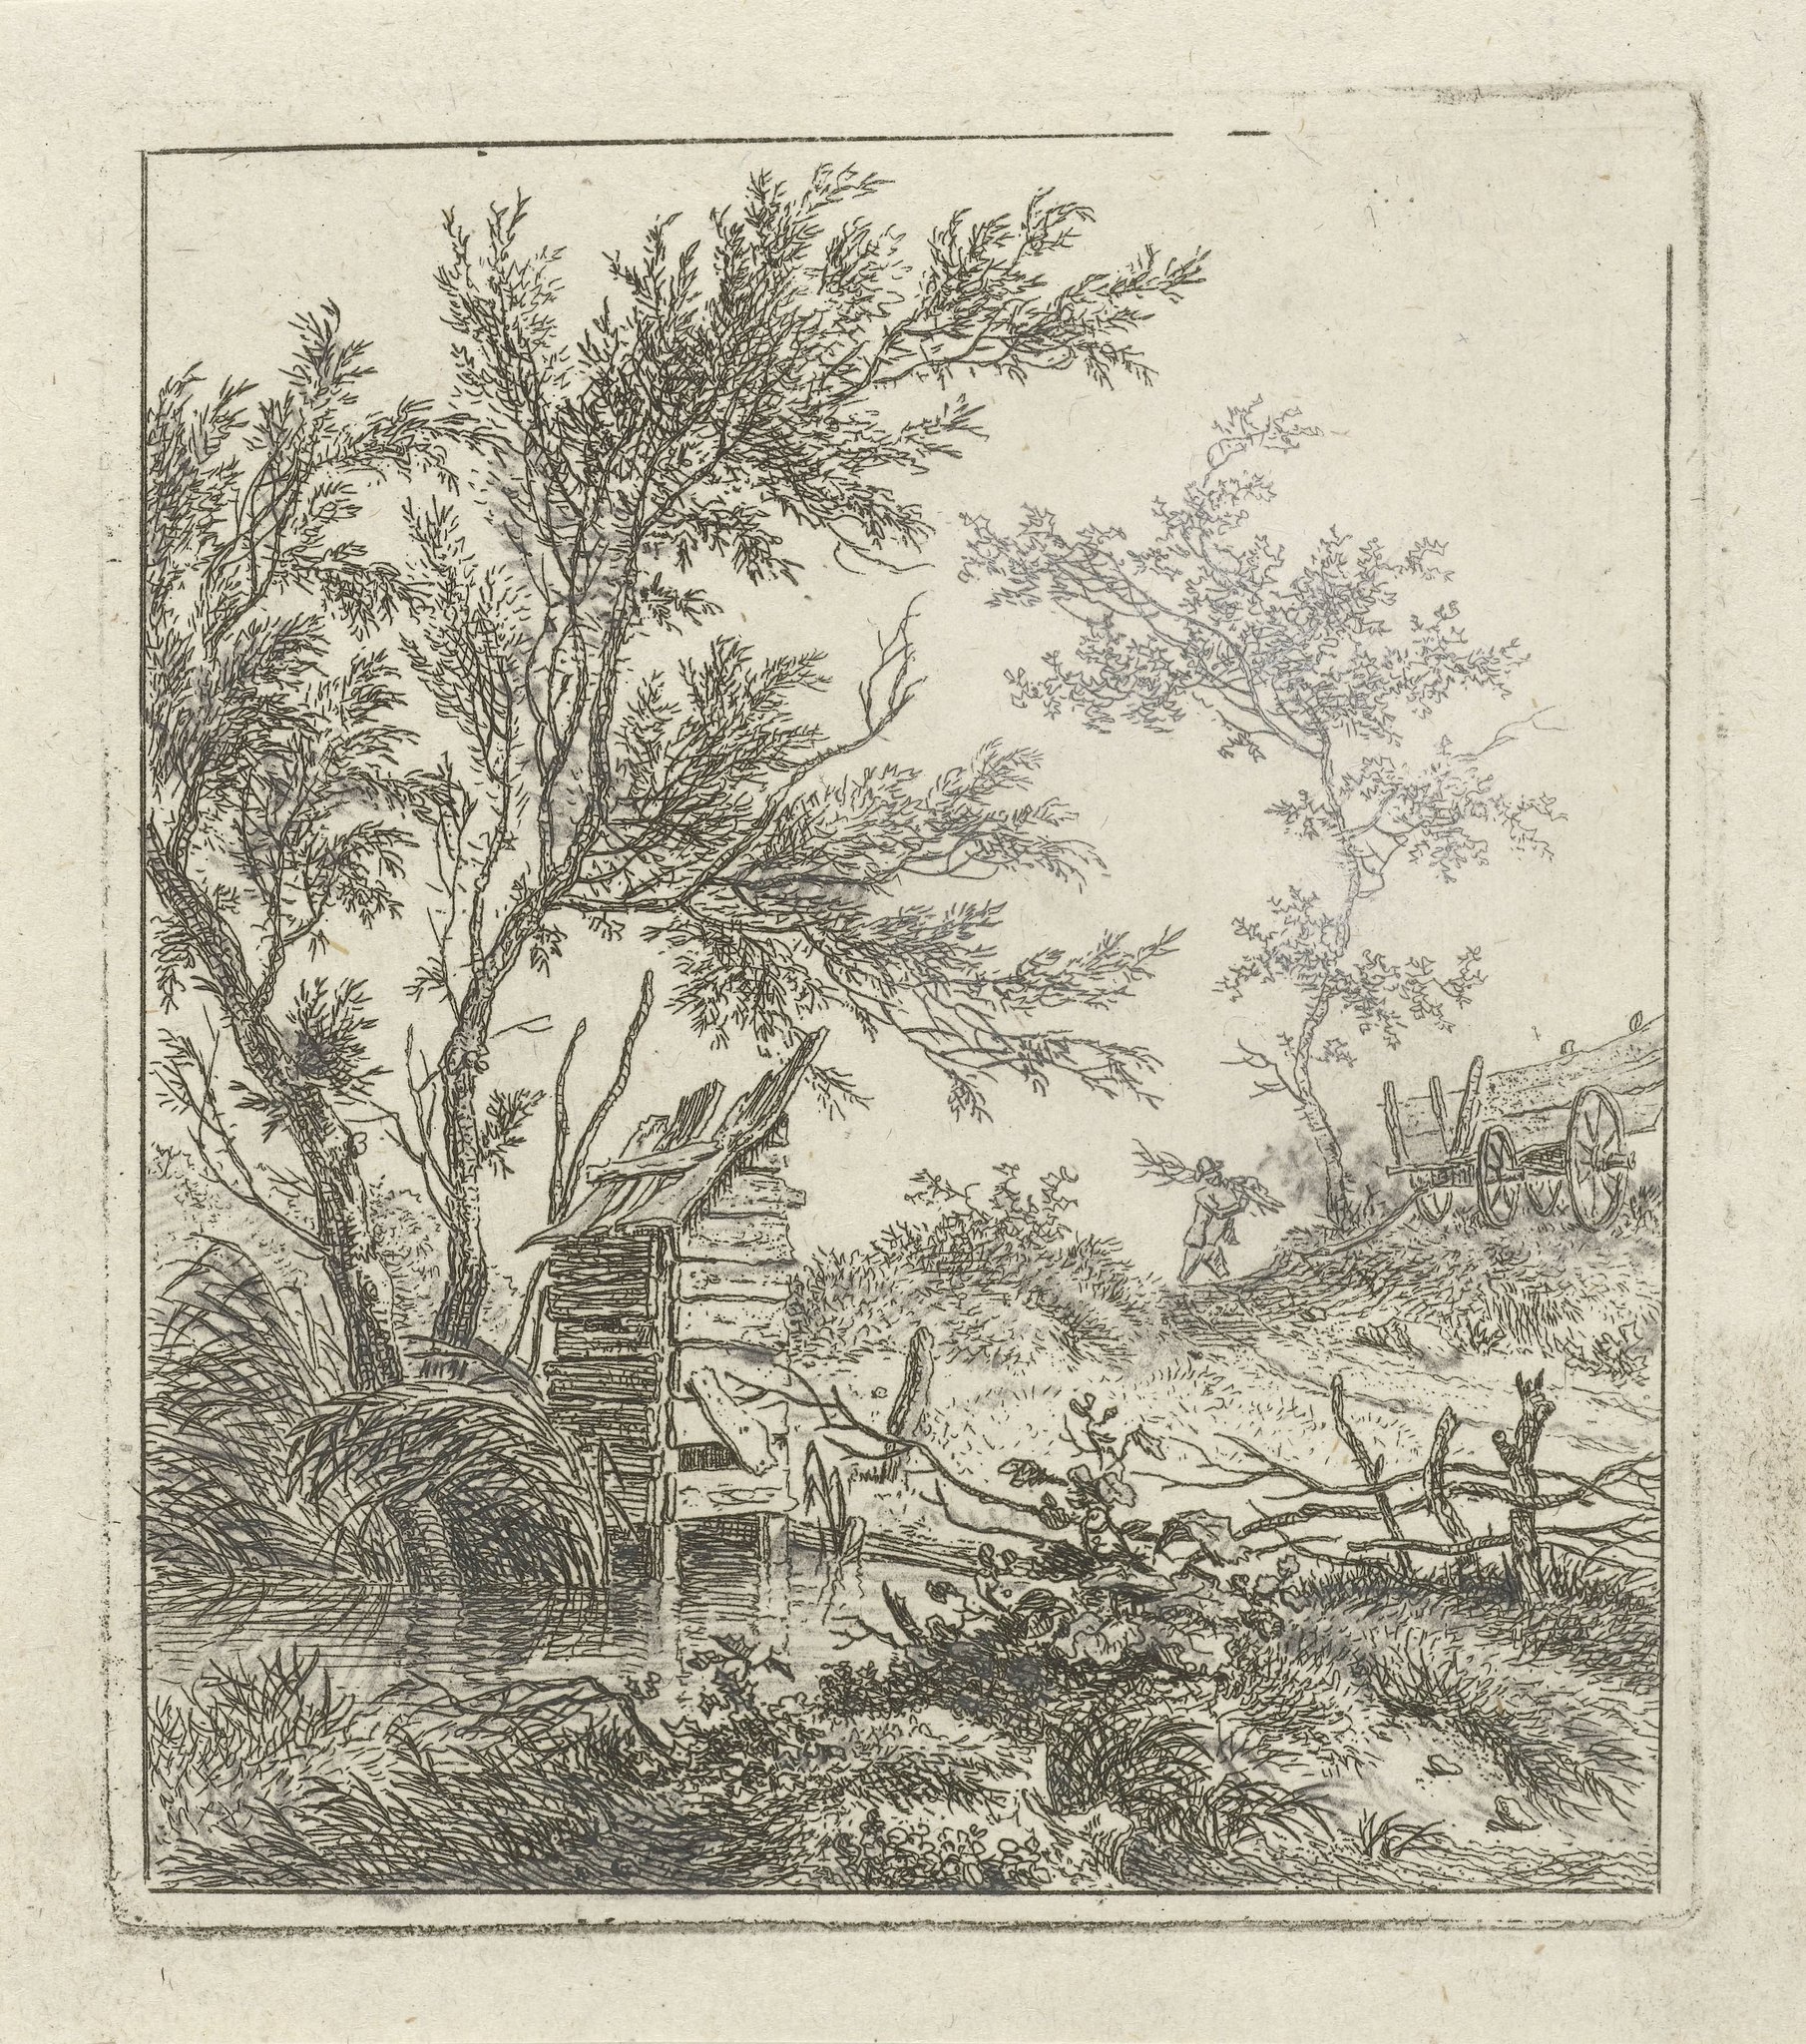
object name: print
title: Landschap met houtsprokkelaar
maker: hermanus fock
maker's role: conservator, draughtsman, painter, print maker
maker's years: 1766-1822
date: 1781-1822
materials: paper, pencil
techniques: etching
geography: amsterdam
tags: woodgathering, woodgatherer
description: Een landschap met een houten gebouwtje onder een boom, aan het water. Op de achtergrond brengt een man sprokkelhout naar een kar.